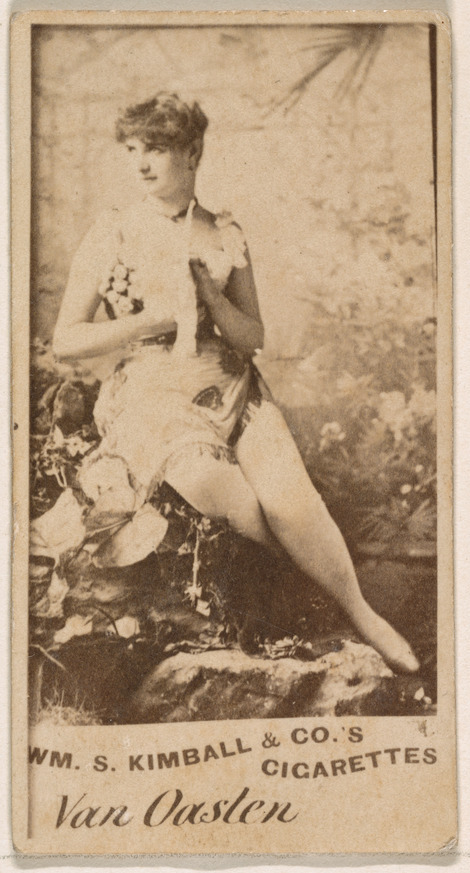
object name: photograph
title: Miss Van Oasten, from the Actresses series (N203) issued by Wm. S. Kimball & Co.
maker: william s. kimball & company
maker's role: publisher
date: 1889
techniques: color lithograph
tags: portraits,women,actresses